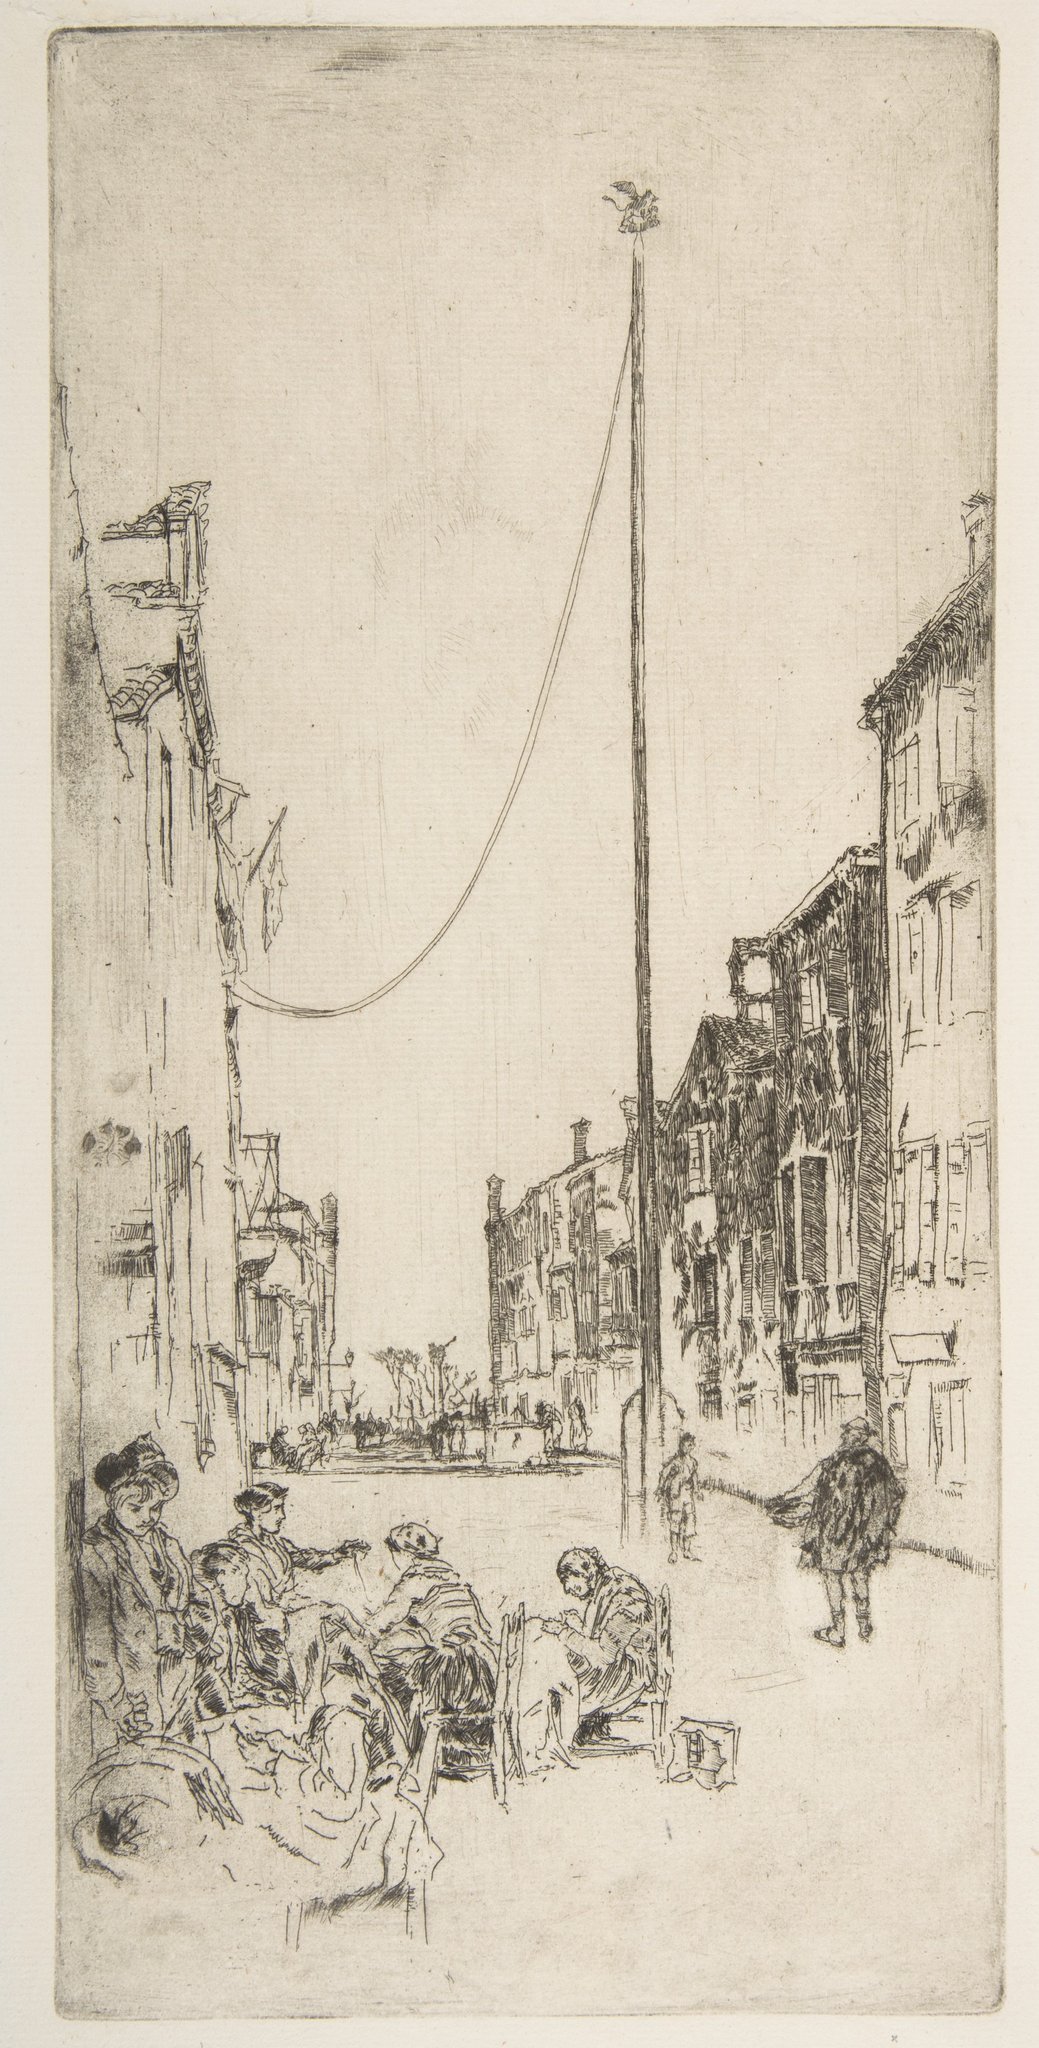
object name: print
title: The Mast (The Venetian Mast)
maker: james mcneill whistler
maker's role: artist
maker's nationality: american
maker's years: 1834-1903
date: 1879-1880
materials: ink, ivory, paper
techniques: drypoint, etching, printing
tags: human figures,buildings,venice